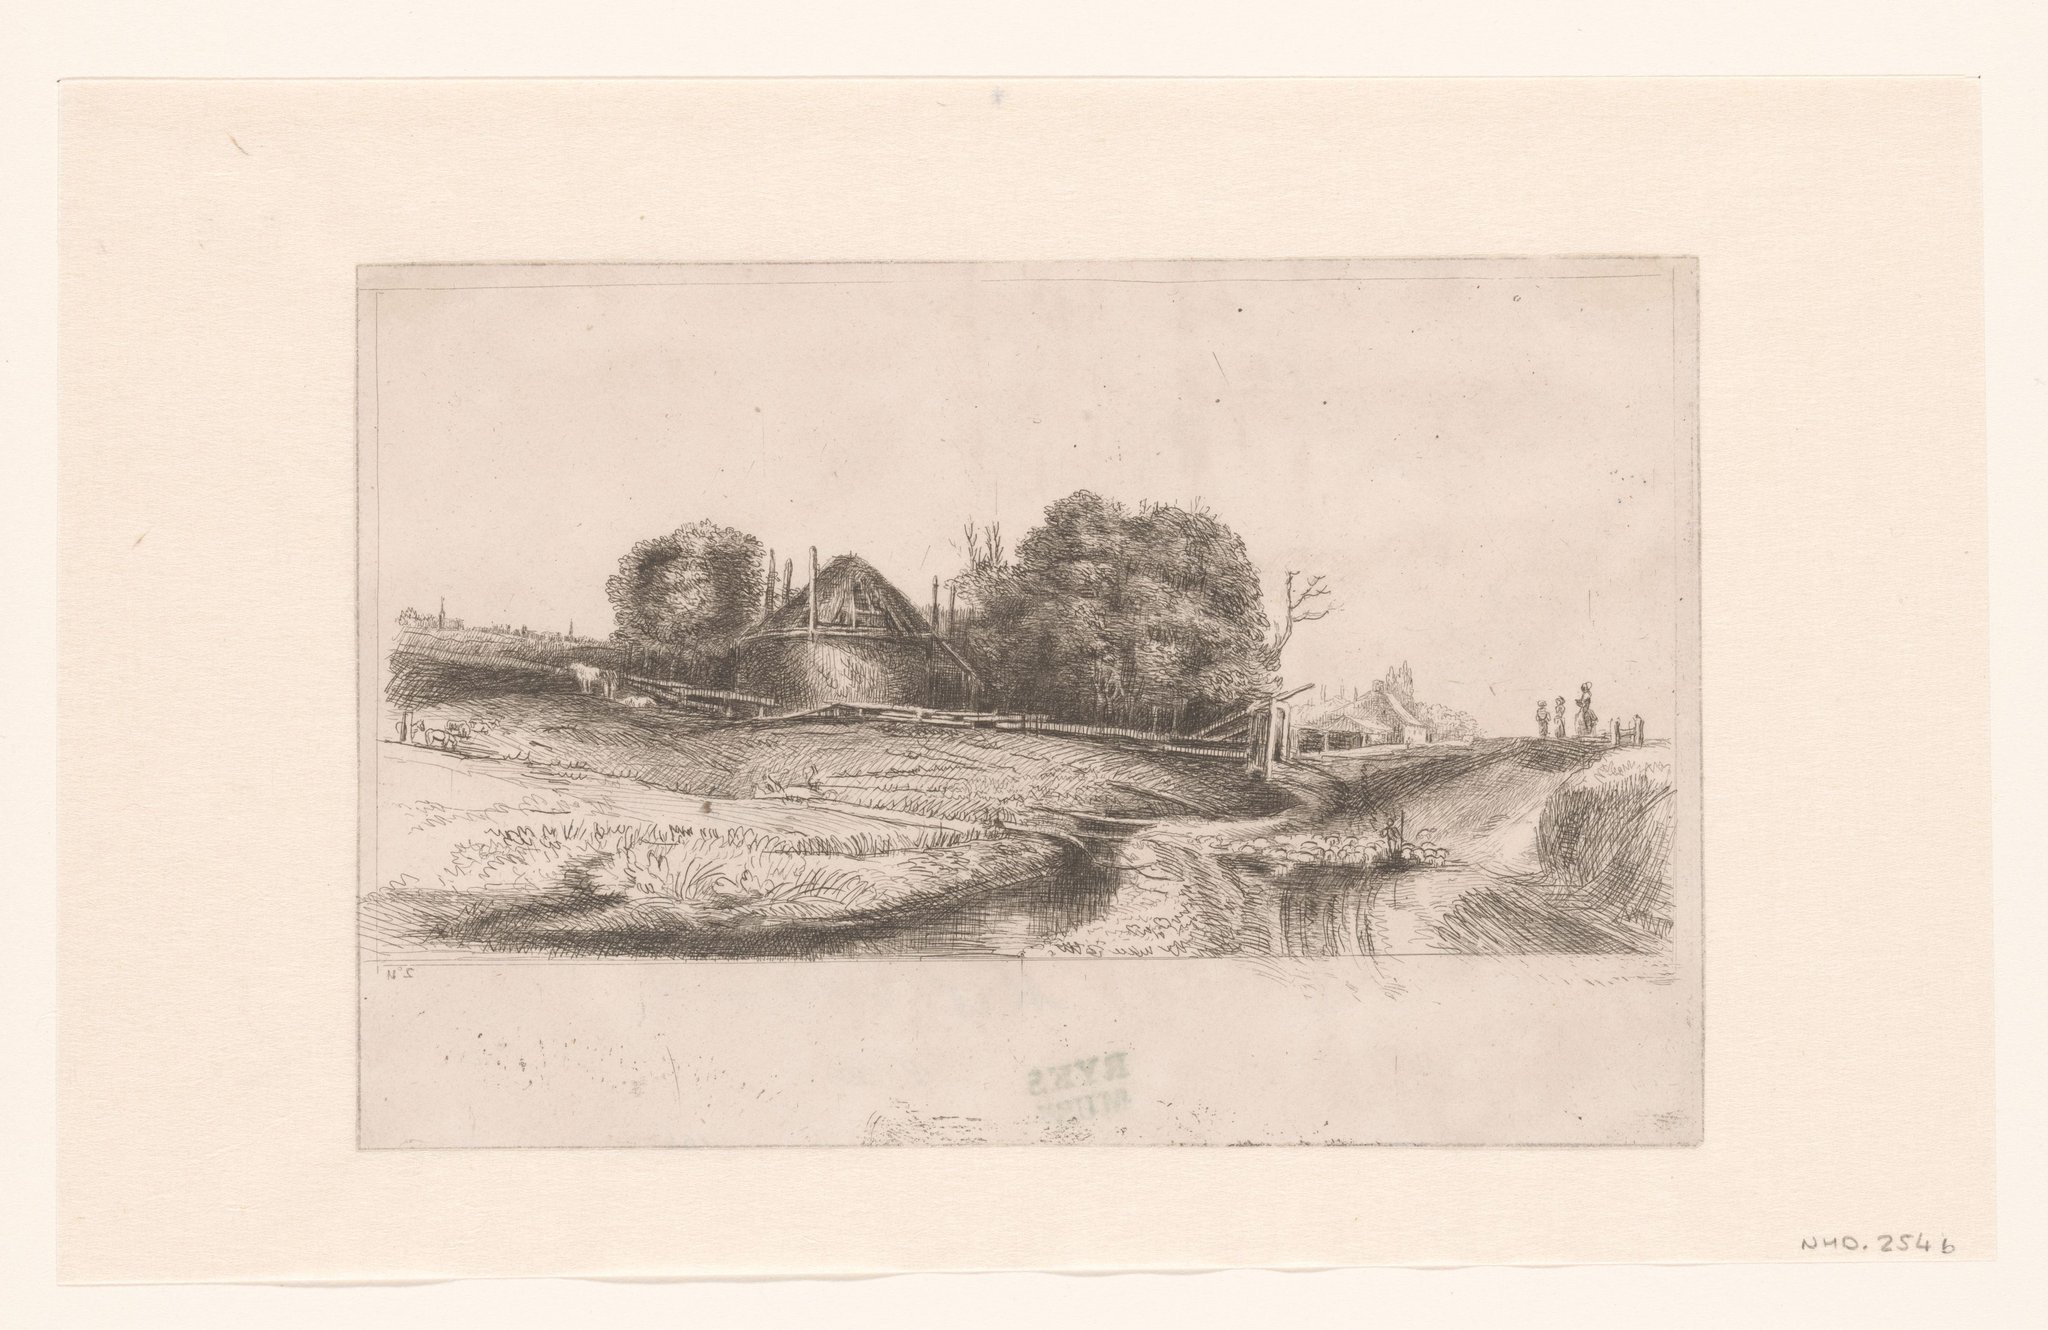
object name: print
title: Cottages and a hay barn on the Diemerdijk with a flock of sheep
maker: claude henri watelet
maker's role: print maker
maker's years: 1718-1786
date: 1728-1786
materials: paper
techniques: etching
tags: monumental adornments (in city)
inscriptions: collector's mark: Lugt 2166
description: Prent afkomstig uit een onbekende publicatie.